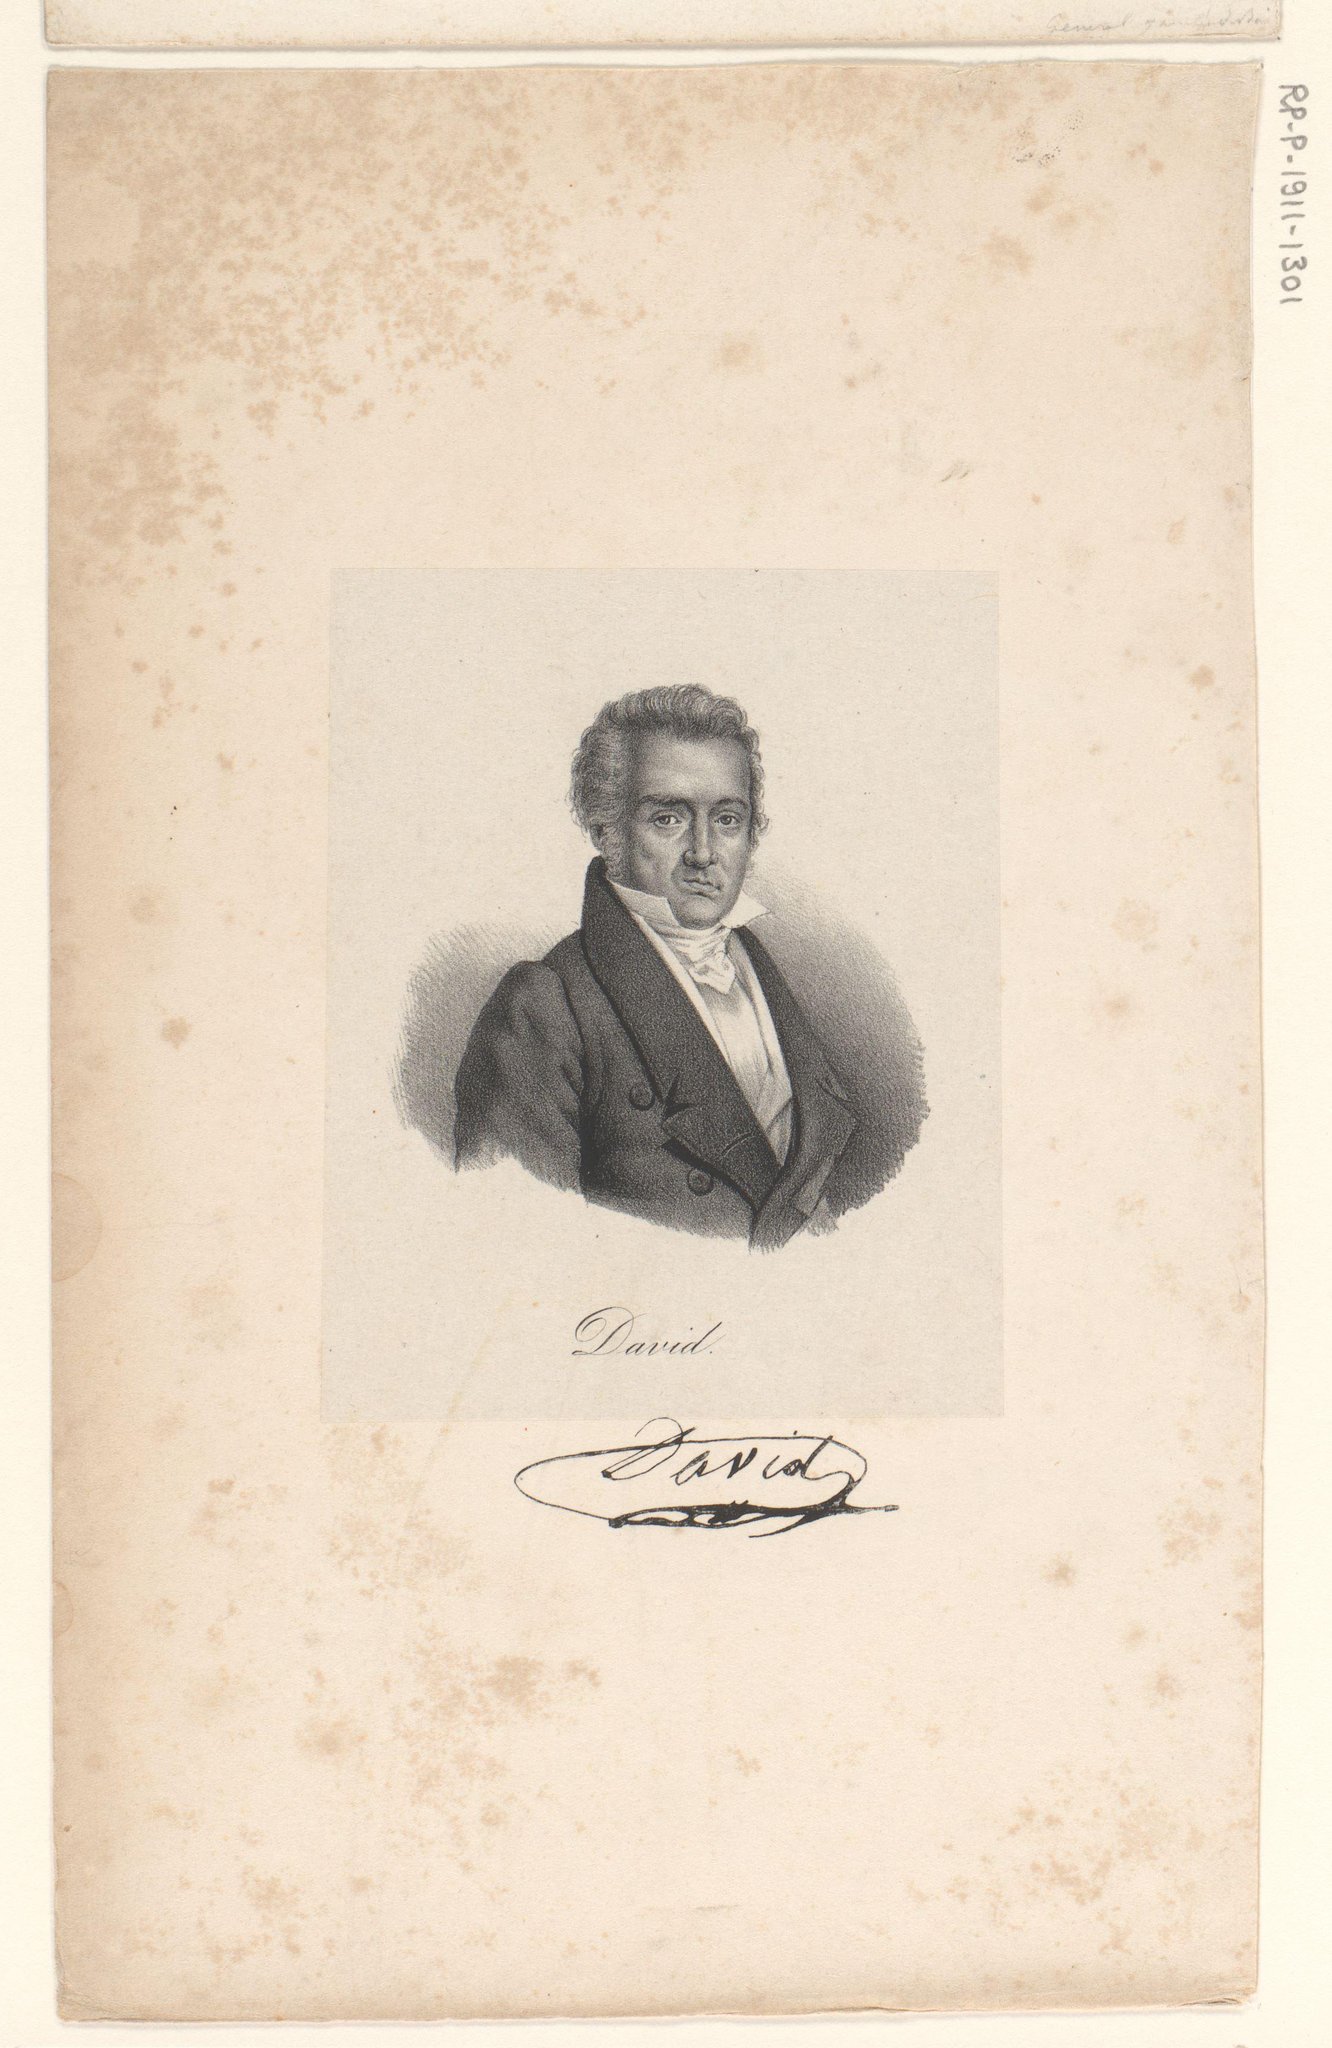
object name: print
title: David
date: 1818-1842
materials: paper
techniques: lithograph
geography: paris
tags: brussels, painter, draughtsman, jacques-louis david, historical persons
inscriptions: collector's mark: Lugt 2228a